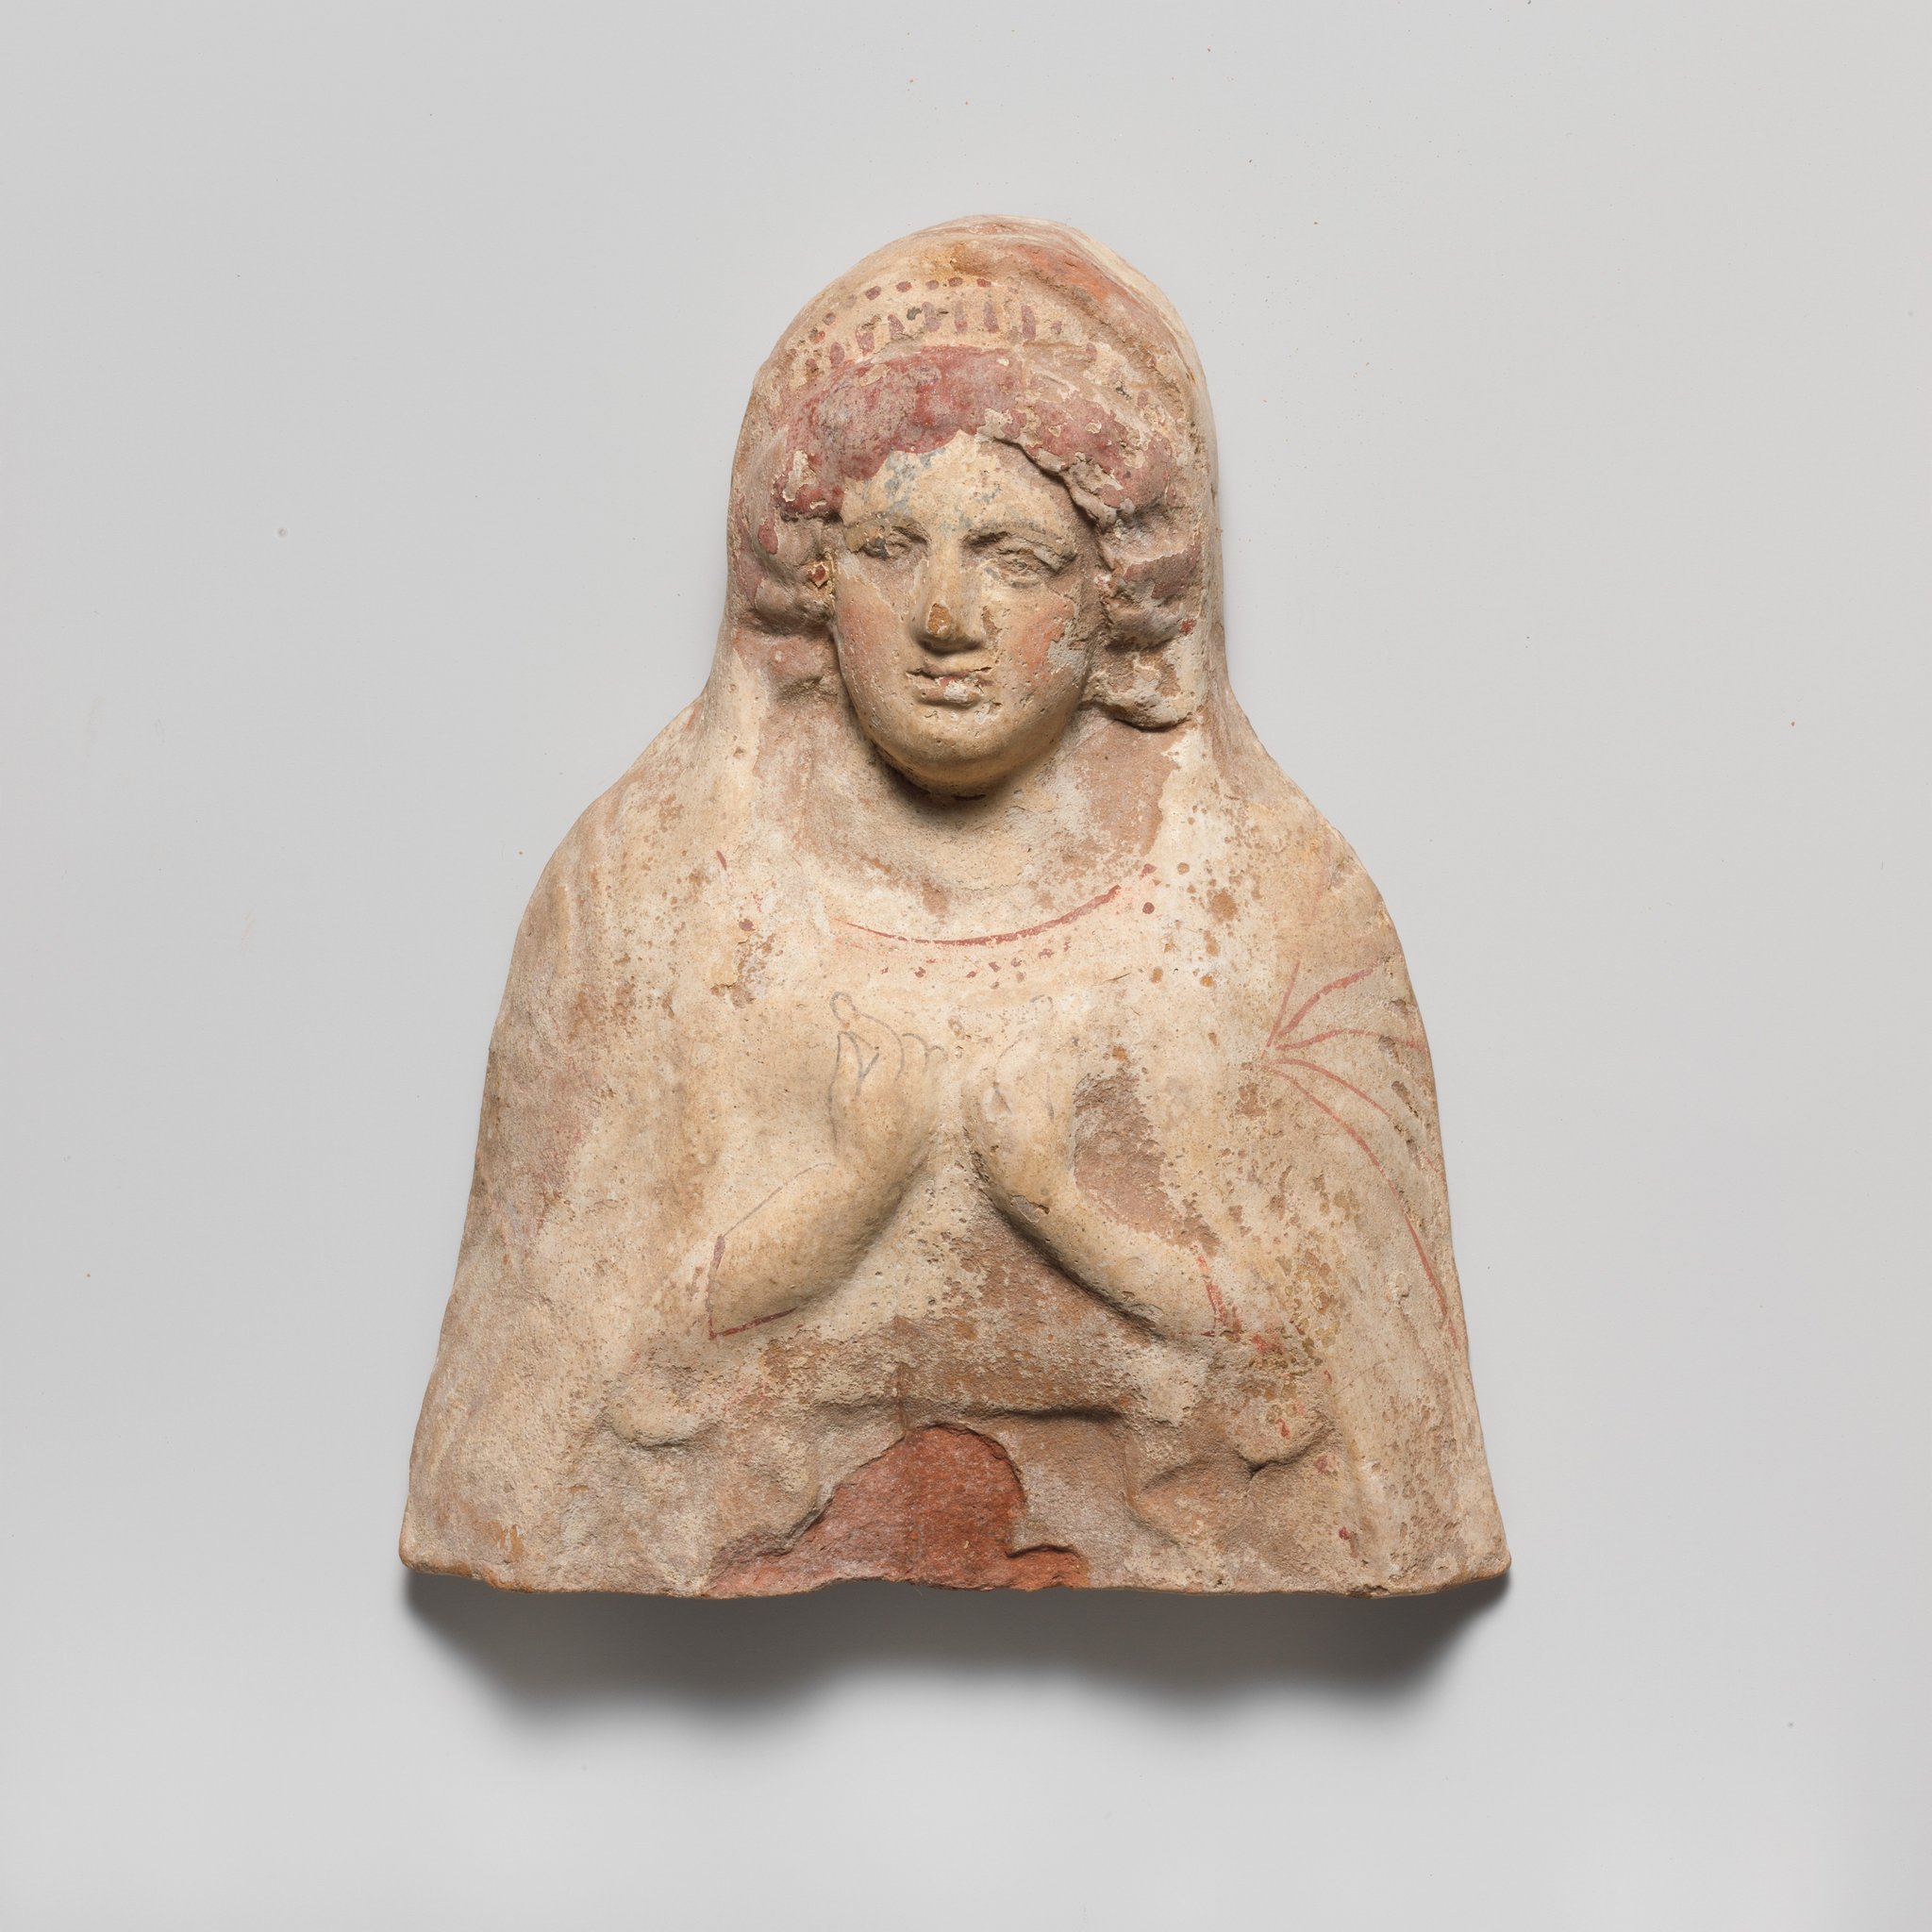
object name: mask of a woman to hip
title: Terracotta relief bust of a woman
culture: east greek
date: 450-401 BCE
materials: terracotta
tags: women